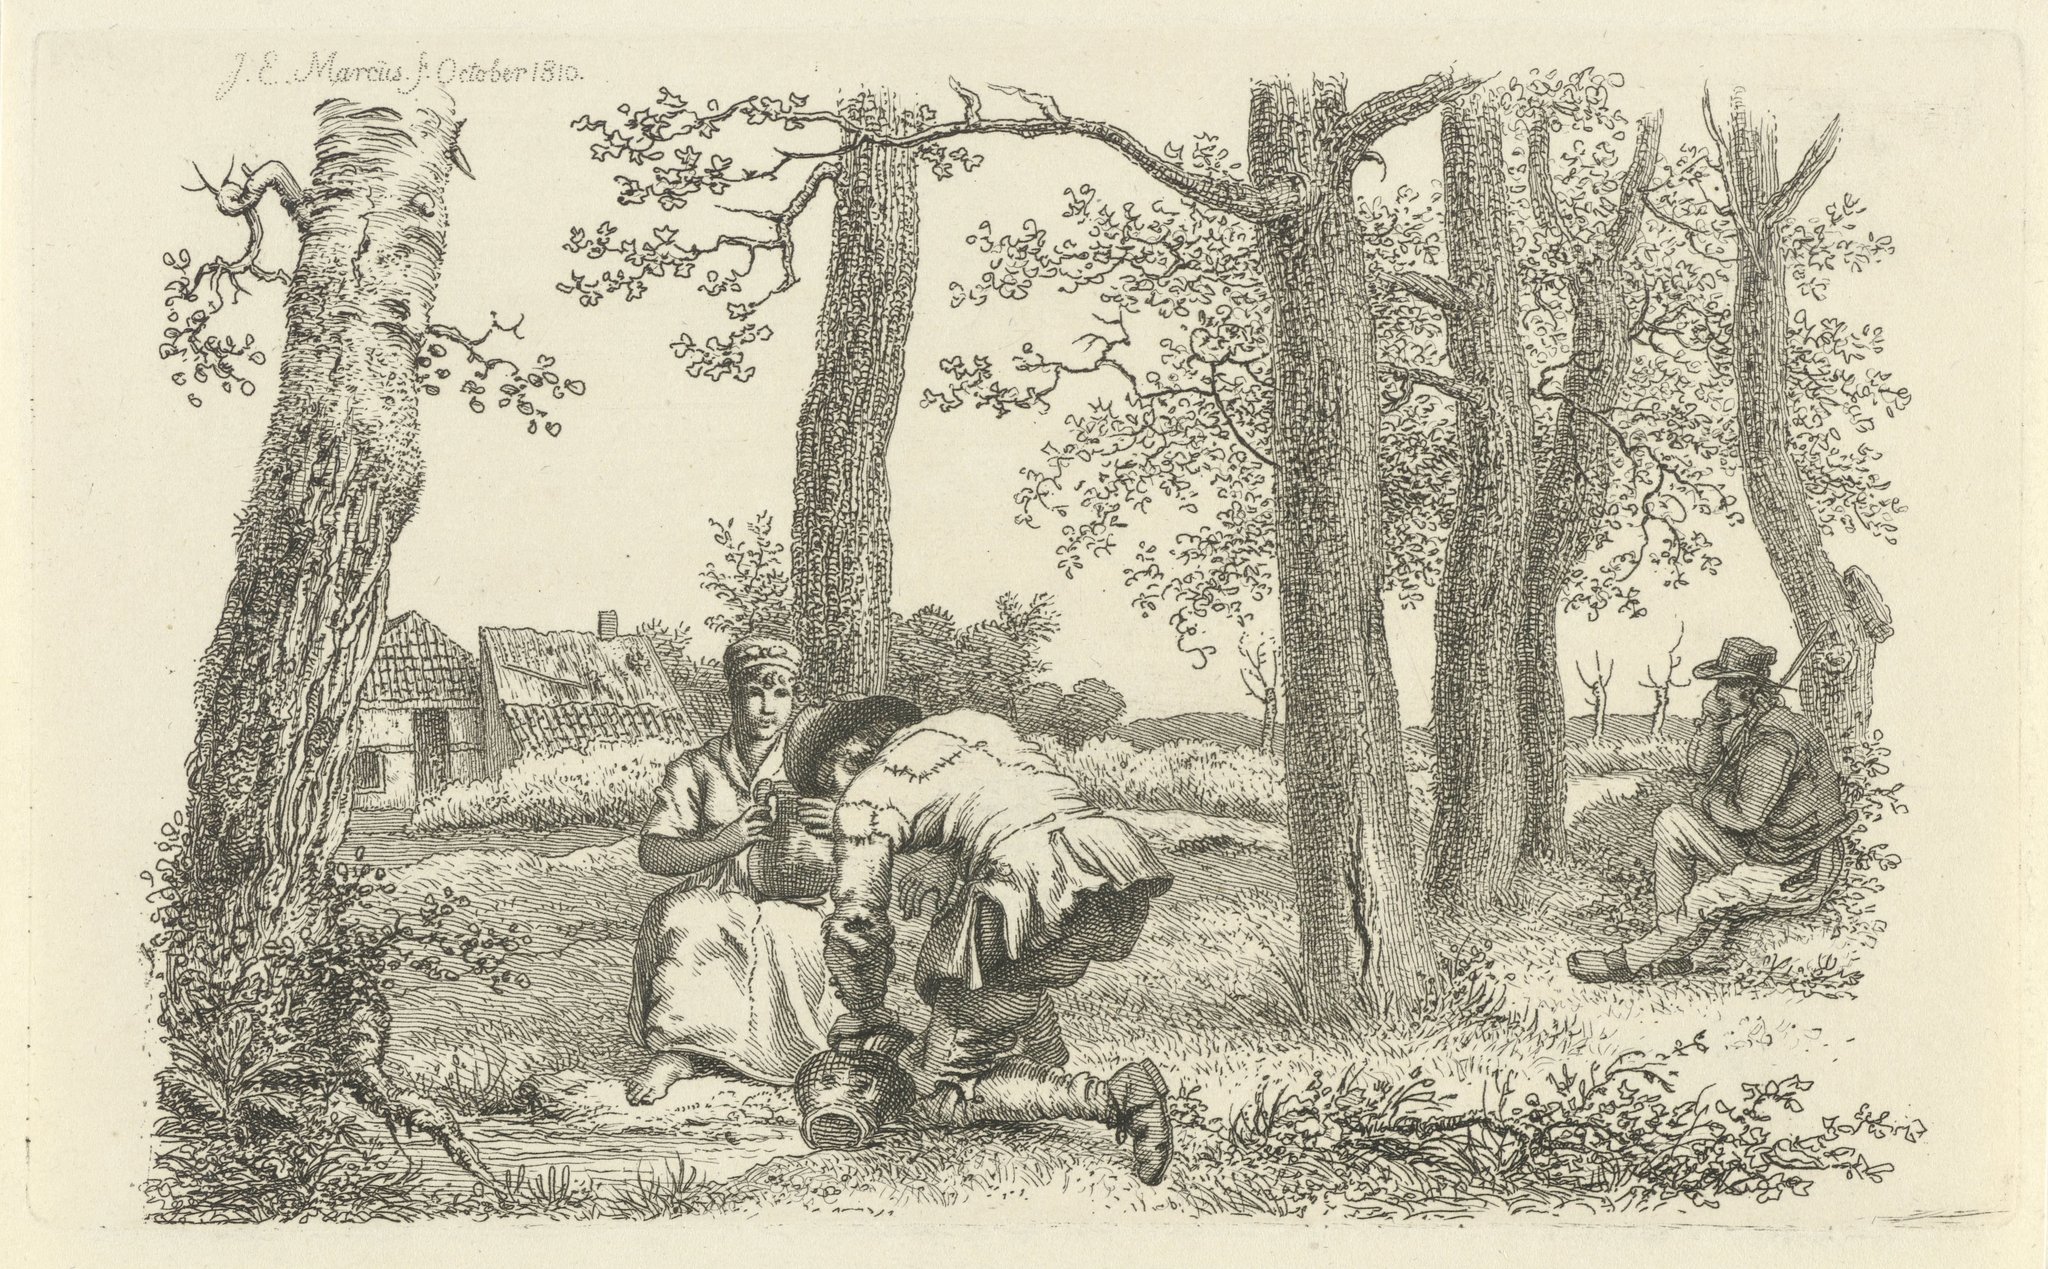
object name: print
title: Figuren tussen bomen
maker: jacob ernst marcus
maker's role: draughtsman, print maker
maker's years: 1774-1826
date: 1810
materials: paper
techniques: etching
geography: amsterdam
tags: trees, kneeling figure, container of ceramics: jar, jug, pot, vase, brook (+ landscape with figures, staffage)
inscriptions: collector's mark: Lugt 2228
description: Serie voor het eerst uitgegeven door Jacob Ernst Marcus onder de titel Studiebeelden en Fragmenten. Amsterdam: ca.1816. Later heruitgegeven als: Studie-prentwerk/ Etudes gravées.